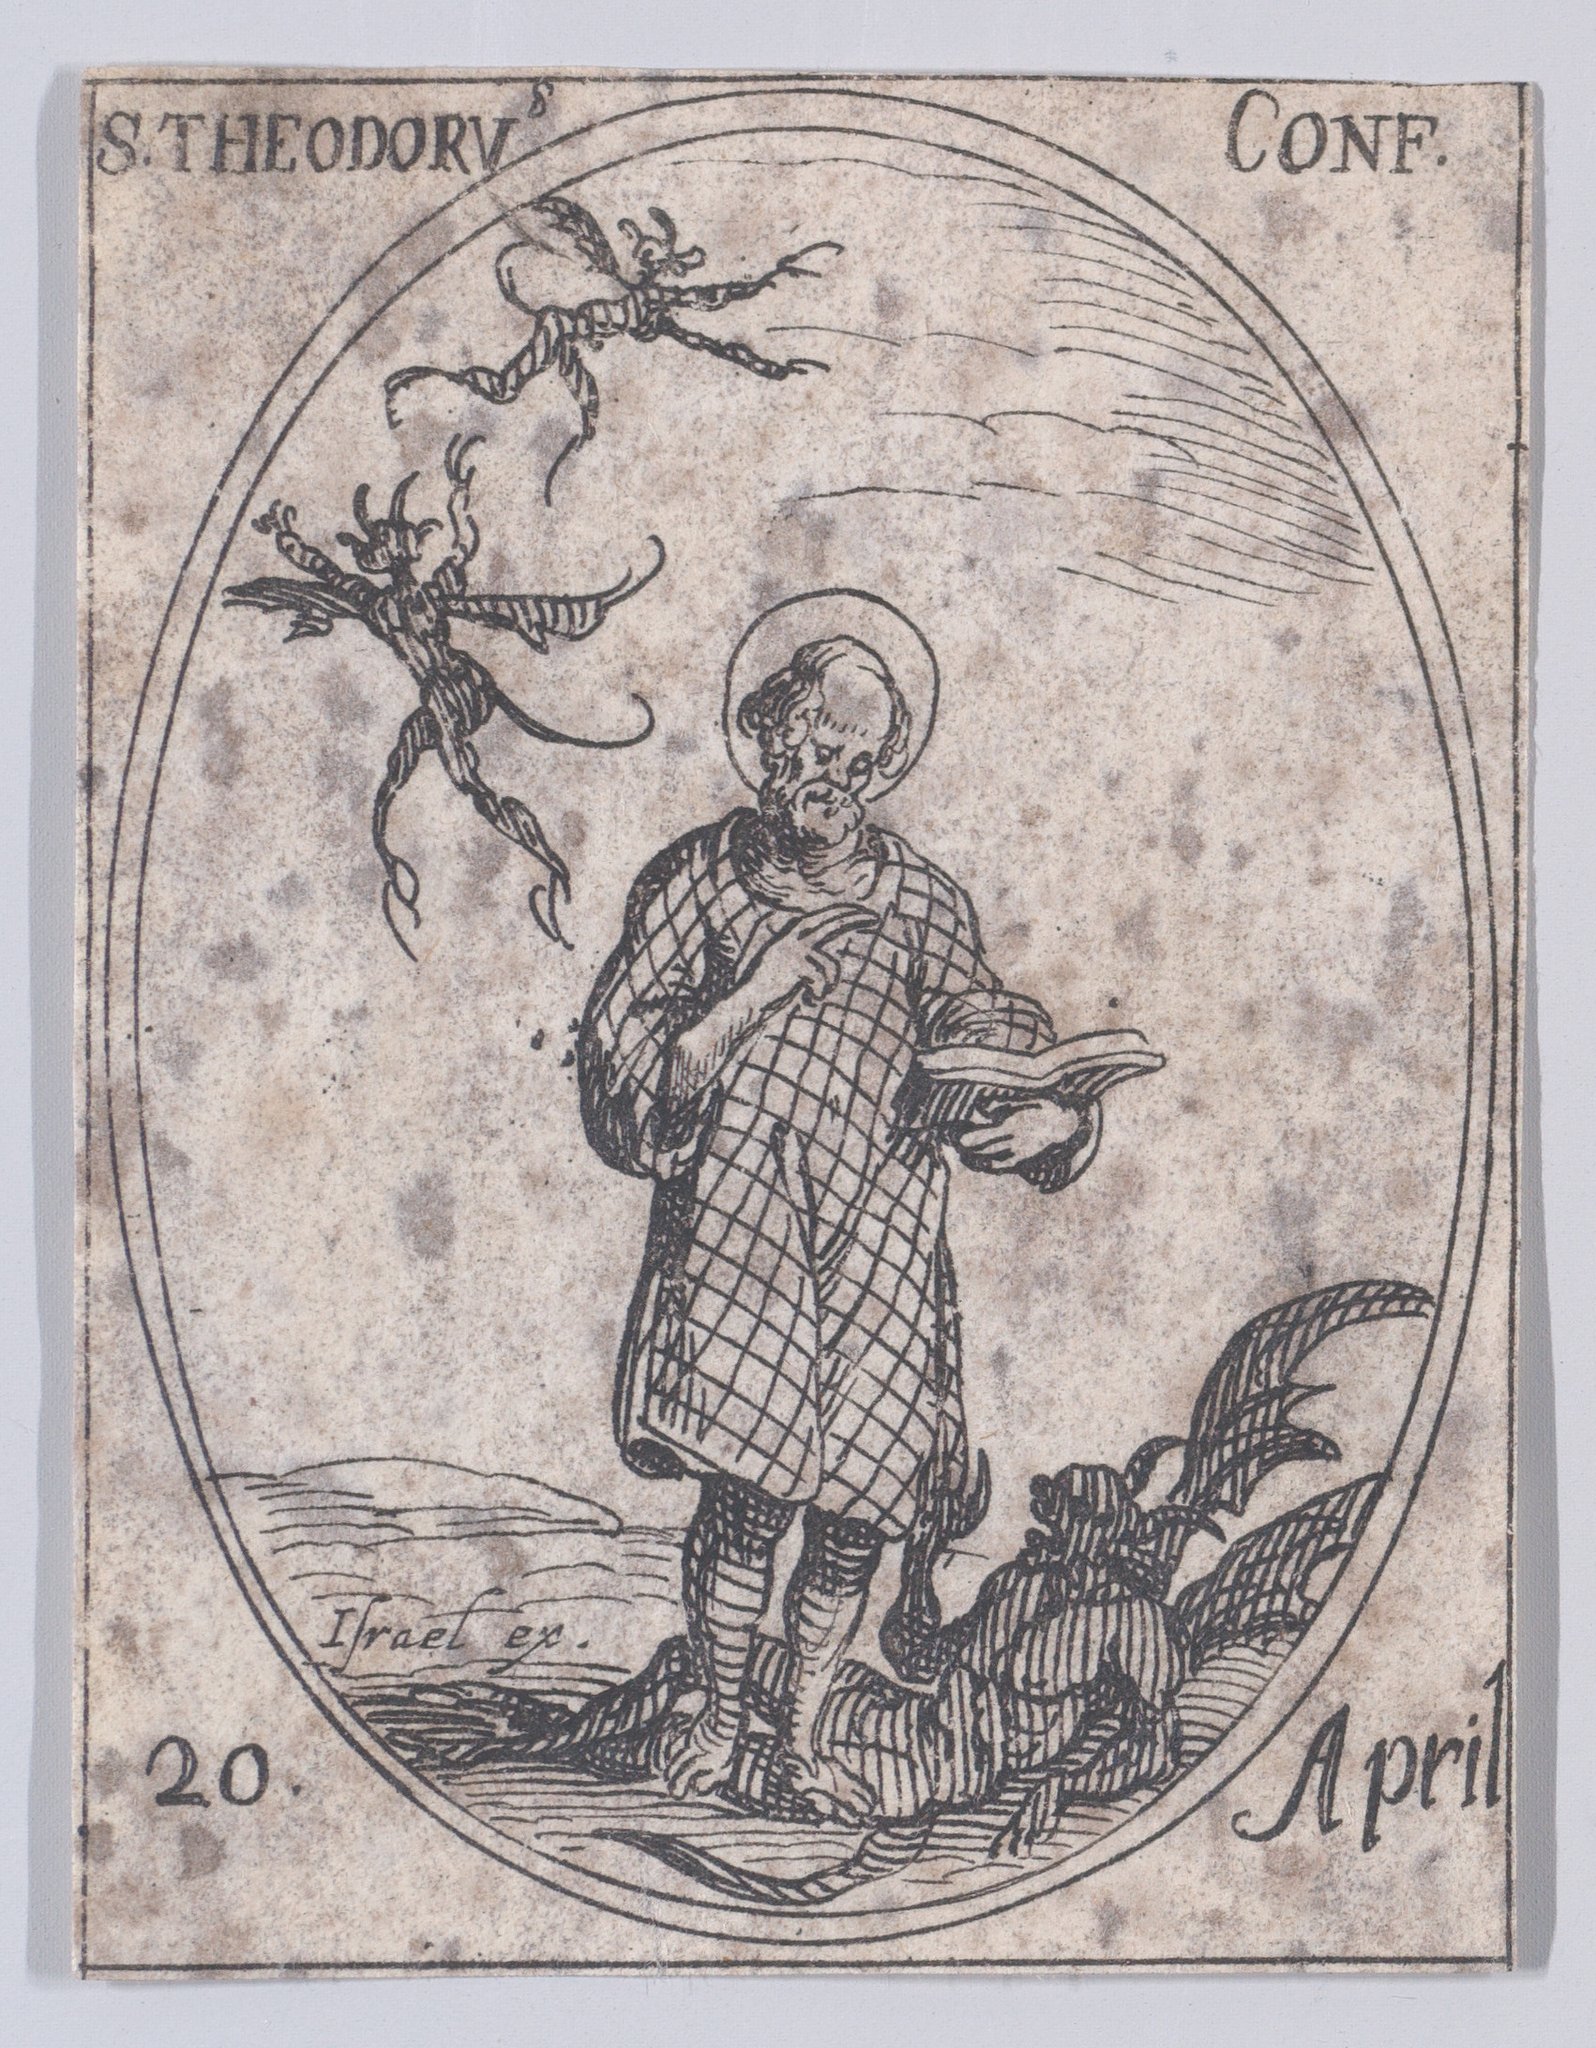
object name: print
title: S. Théodore, confesseur (St. Theodore Trichinas, Confessor), April 20th, from "Les Images De Tous Les Saincts et Saintes de L'Année" (Images of All of the Saints and Religious Events of the Year)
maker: jacques callot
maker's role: artist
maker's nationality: french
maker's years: 1592-1635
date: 1636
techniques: etching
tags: men,demons,saints